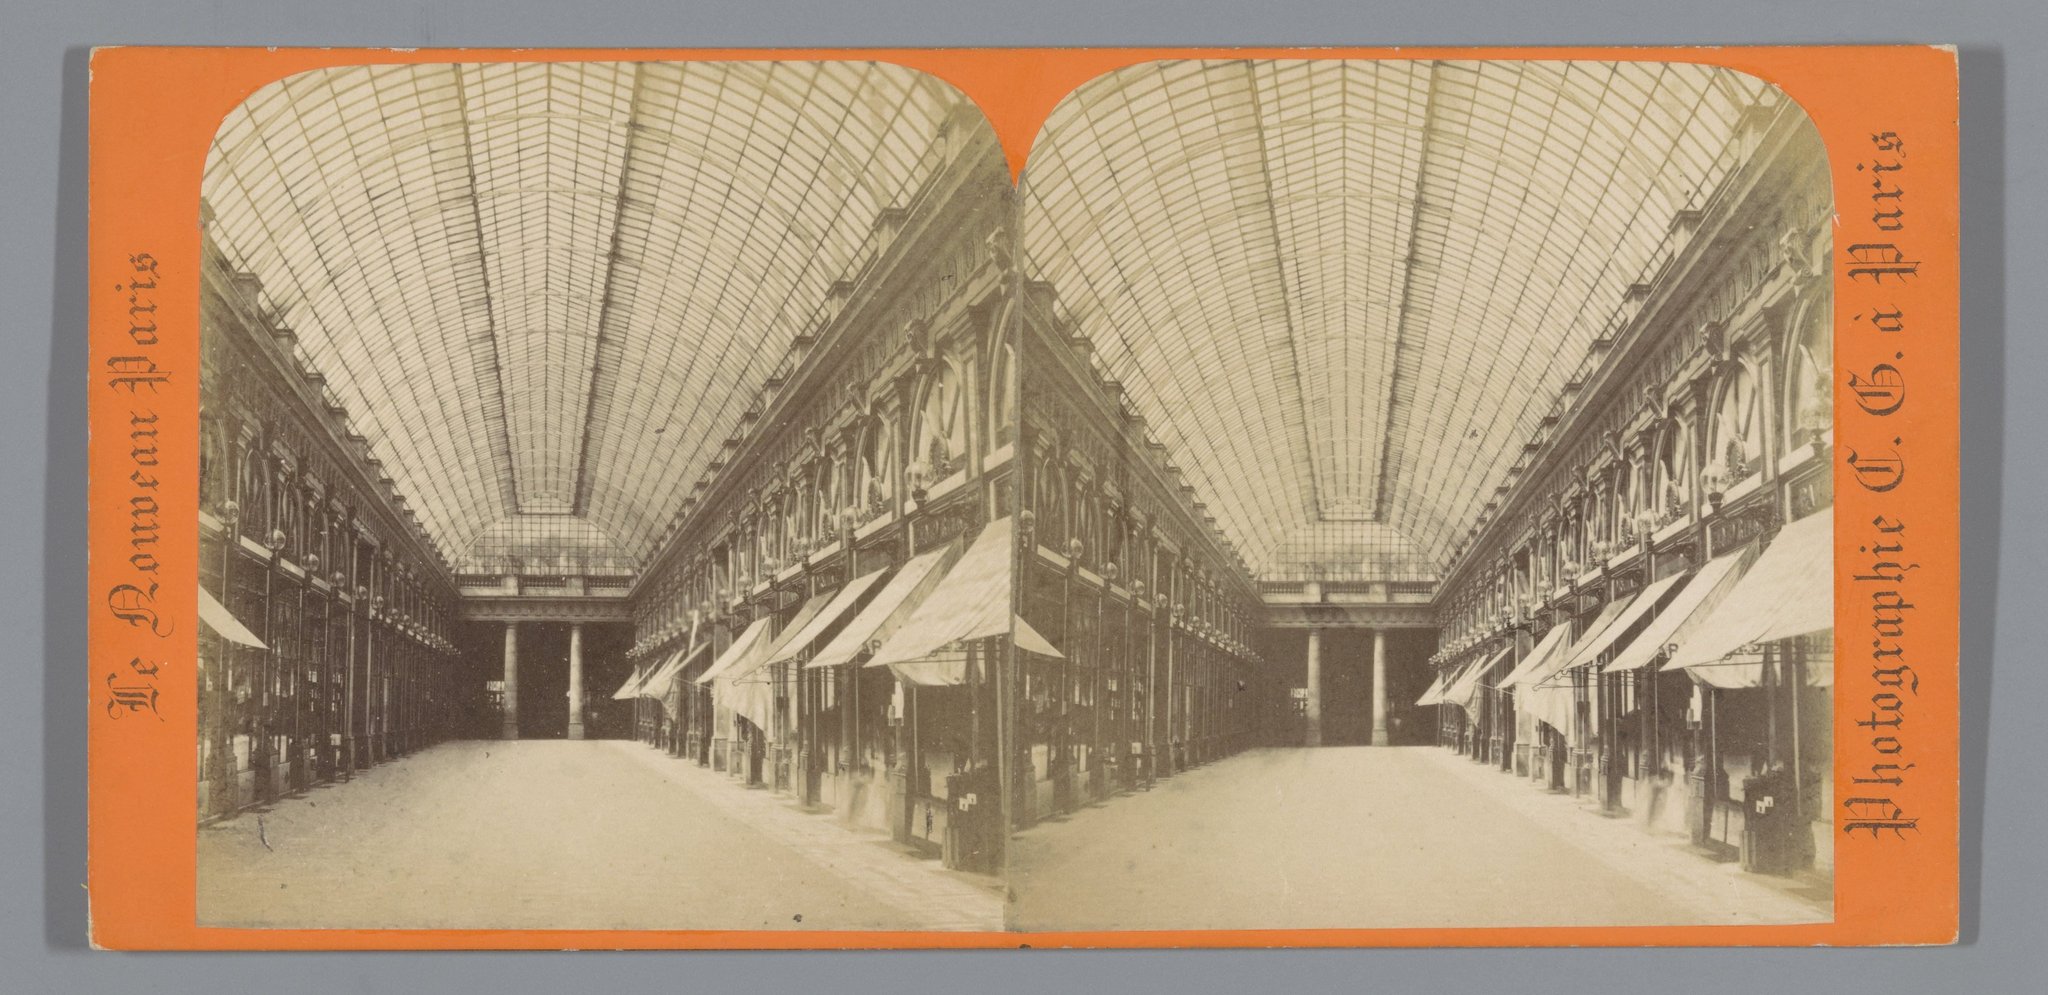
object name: stereograph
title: Le Nouveau Paris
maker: charles gérard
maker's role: fotograaf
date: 1860-1870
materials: cardboard, photographic support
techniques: albumen print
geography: palais-royal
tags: gallery (spacious corridor)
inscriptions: inscription: ‘Photographie C. G. à Paris.’, inscription: ‘Galerie d'Orleans au palais royal’